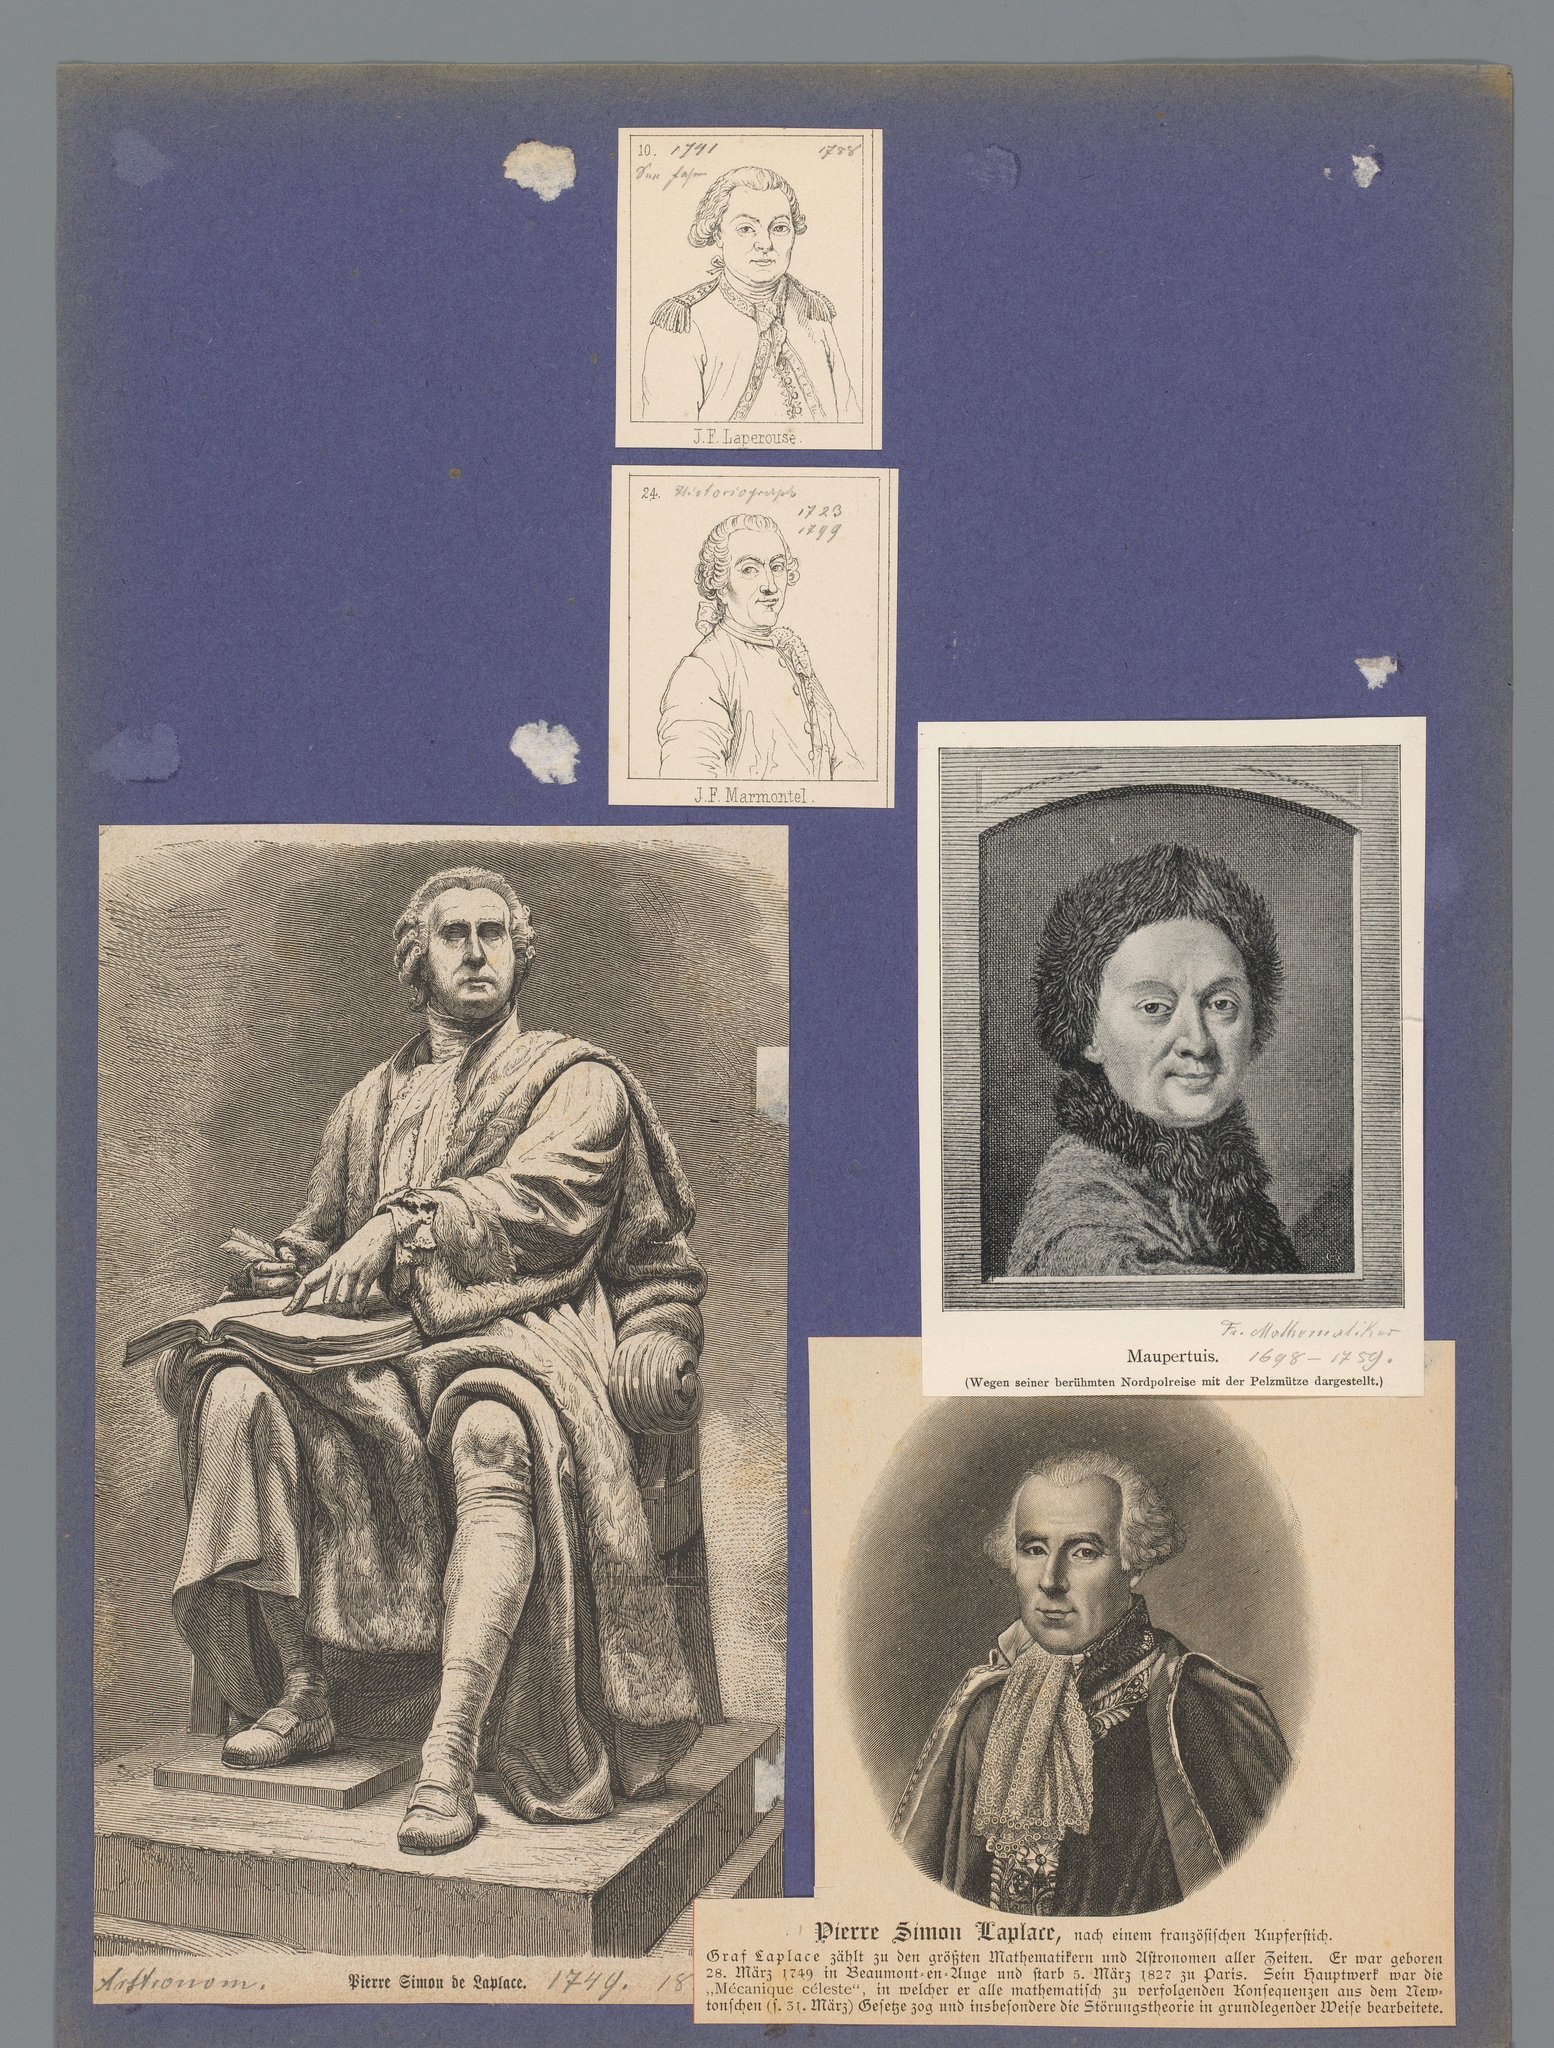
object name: print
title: Blad met vijf portretten van historische mannen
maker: Anonymous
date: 1850-1900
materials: paper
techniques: snipping, engraving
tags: naval officer, paris, jean françois marmontel, historical persons, portrait of a writer, scholar, philosopher (+ portrait of scholar, scientist)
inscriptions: signature: ‘HG [over elkaar gedrukt] / Leipzig’